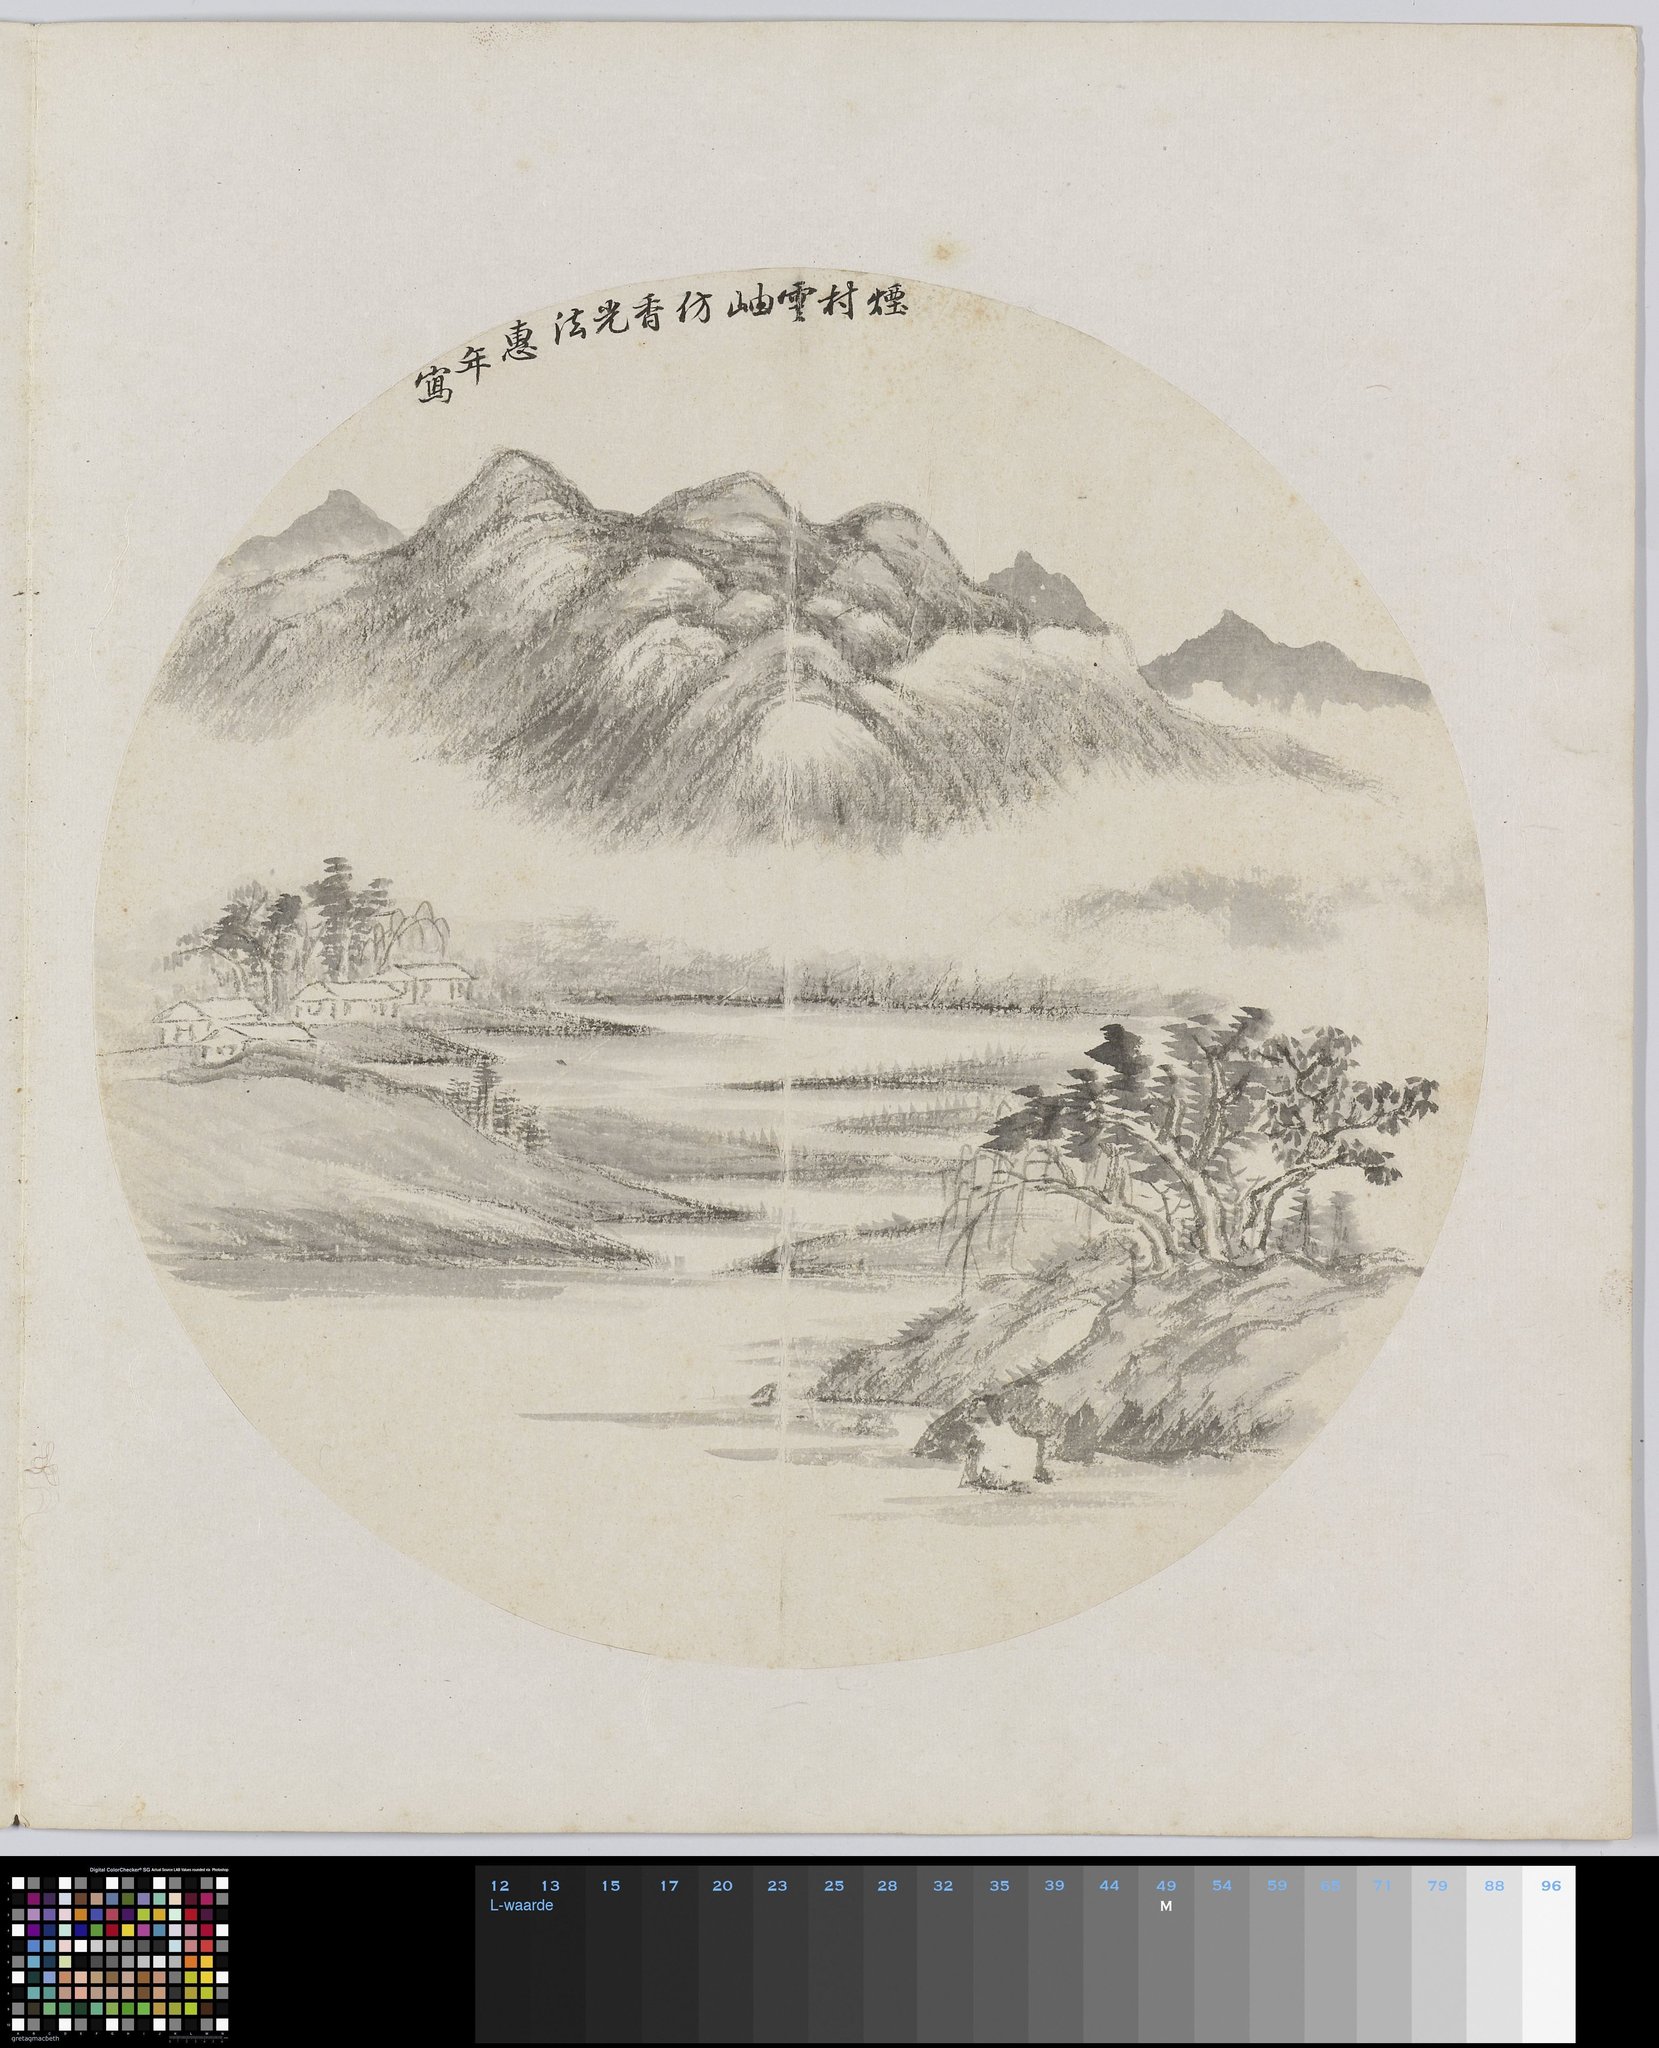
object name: painting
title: Albumblad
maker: hui nian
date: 1850-1900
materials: ink, paper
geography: china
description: Albumblad met een landschap. Behoort twee albums met 24 landschappen in de stijl van diverse meesters.